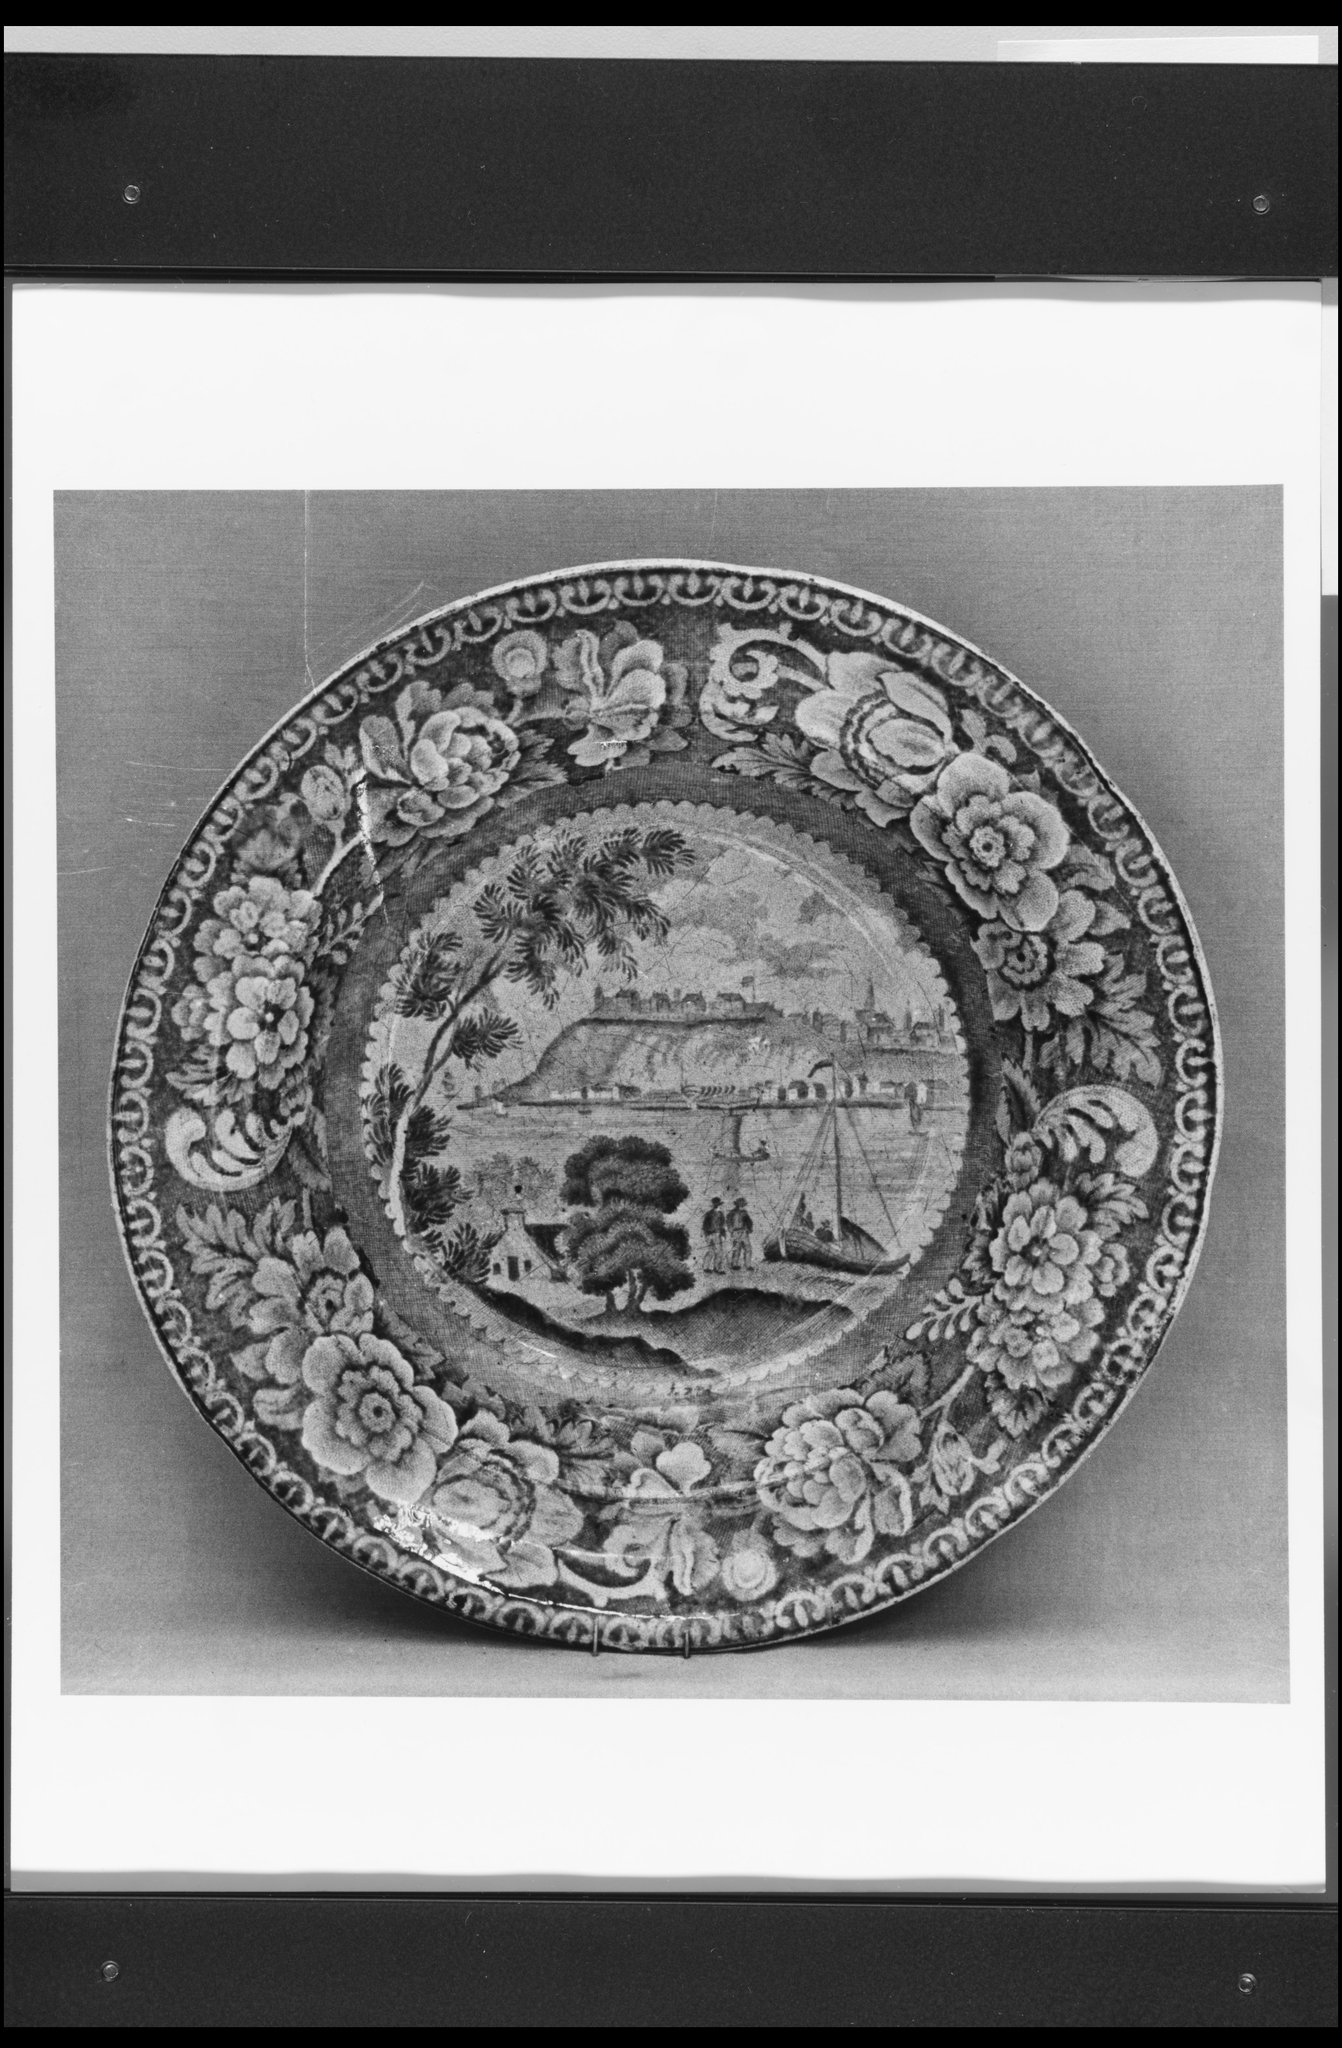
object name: plate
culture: british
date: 1830-1835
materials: earthenware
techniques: transfer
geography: england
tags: landscapes,boats